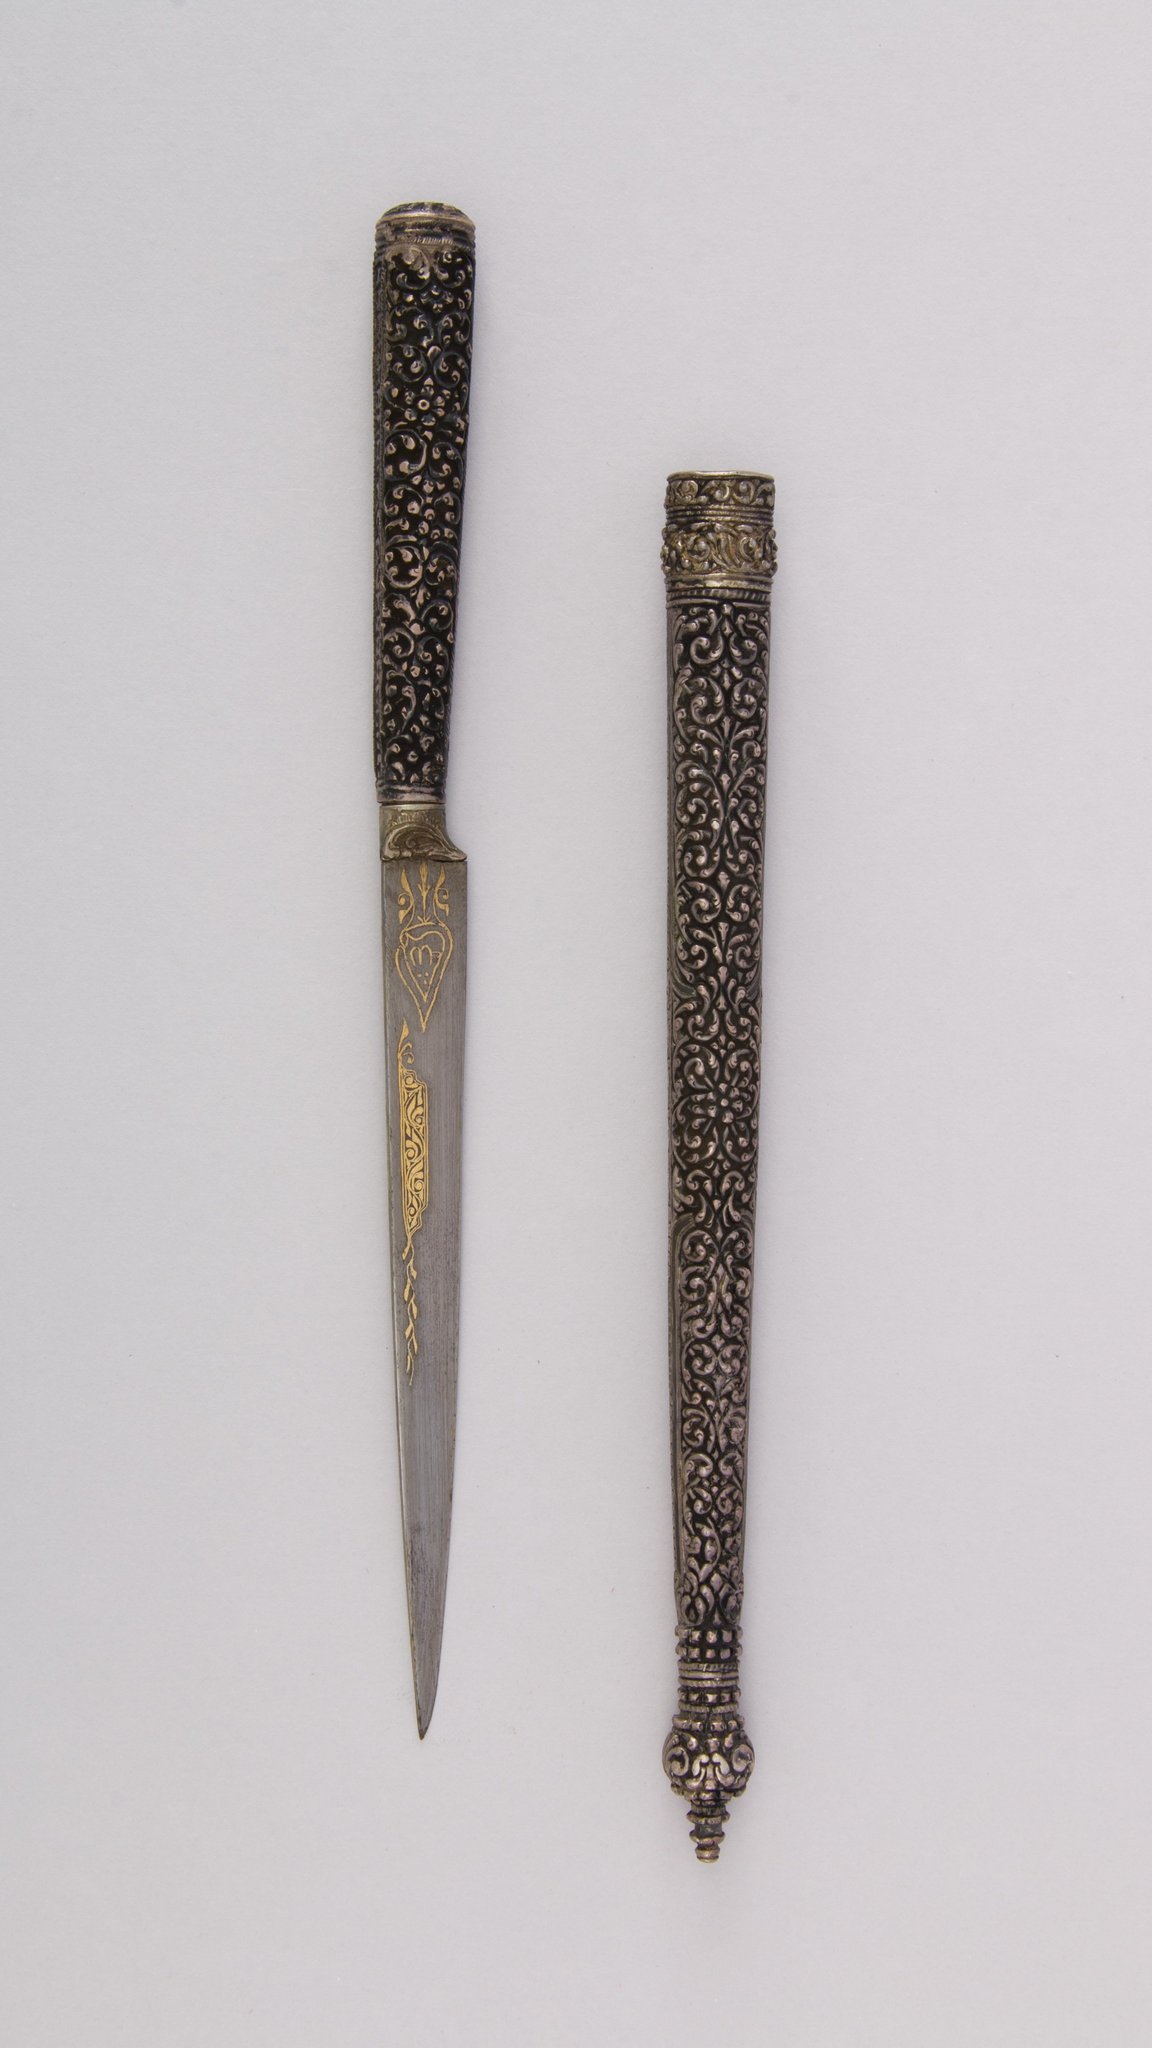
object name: dagger with sheath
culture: persian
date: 1801-1900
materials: gold, silver, steel, wood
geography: iran